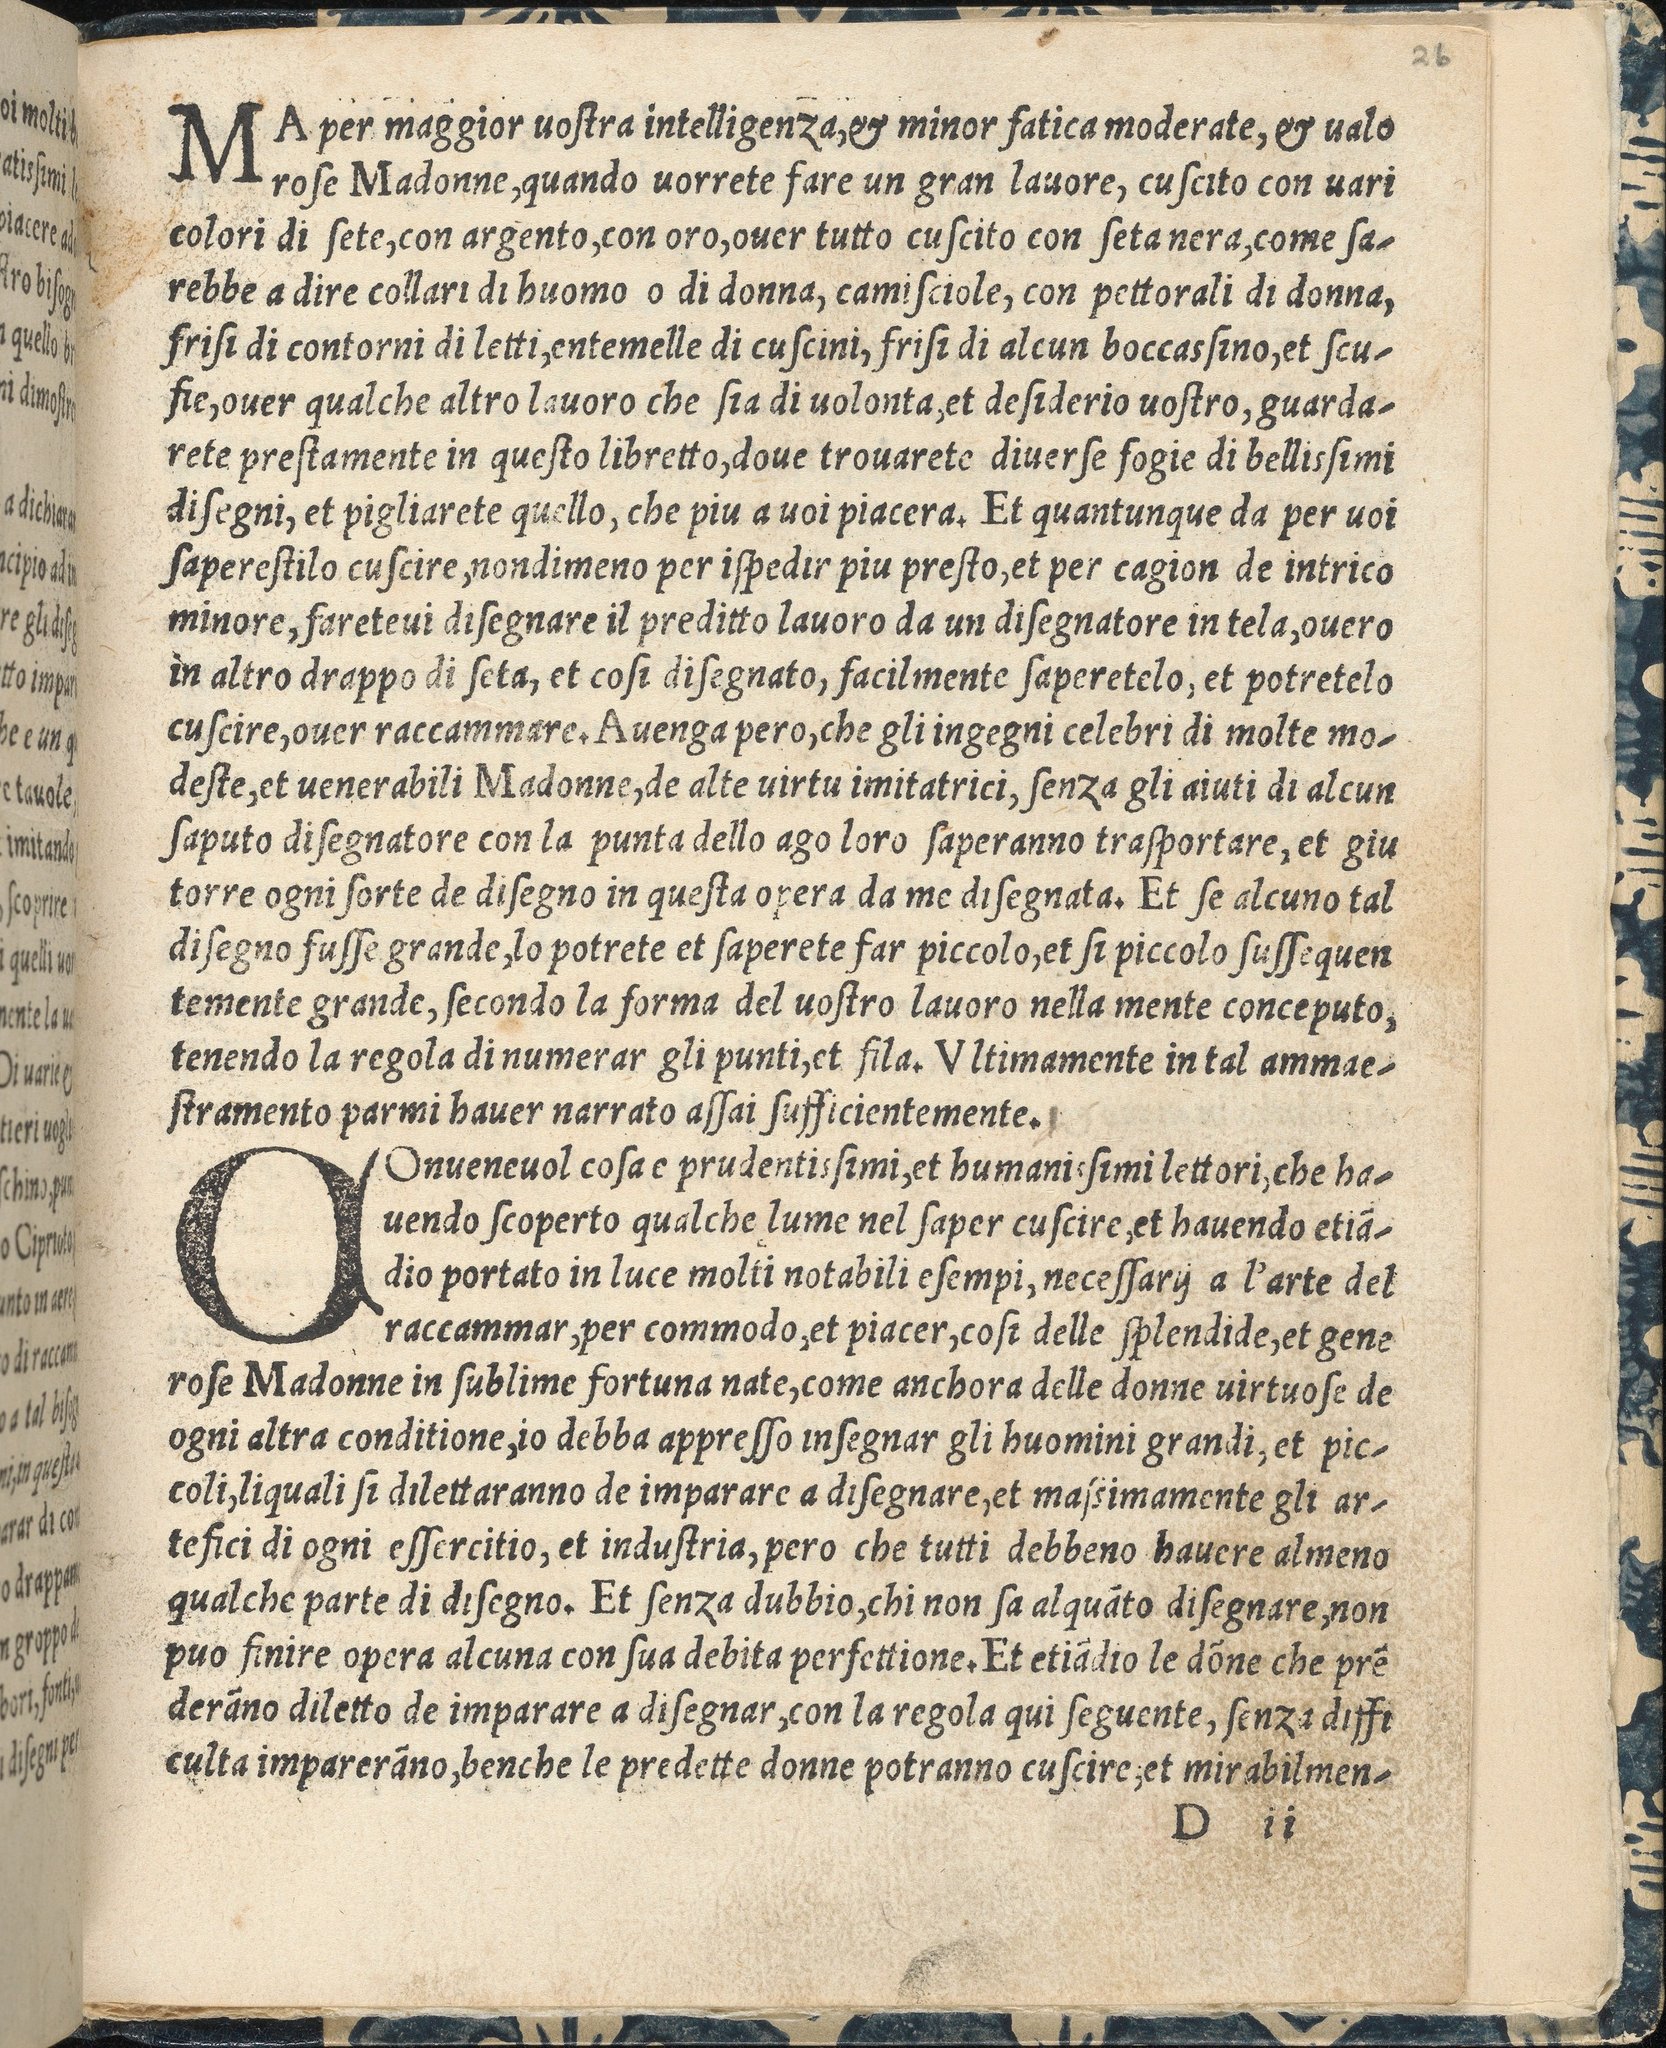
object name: book print ornament architecture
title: Essempio di recammi, page 26 (recto)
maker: giovanni antonio tagliente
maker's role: author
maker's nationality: italian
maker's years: 1465-1528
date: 1530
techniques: woodcut